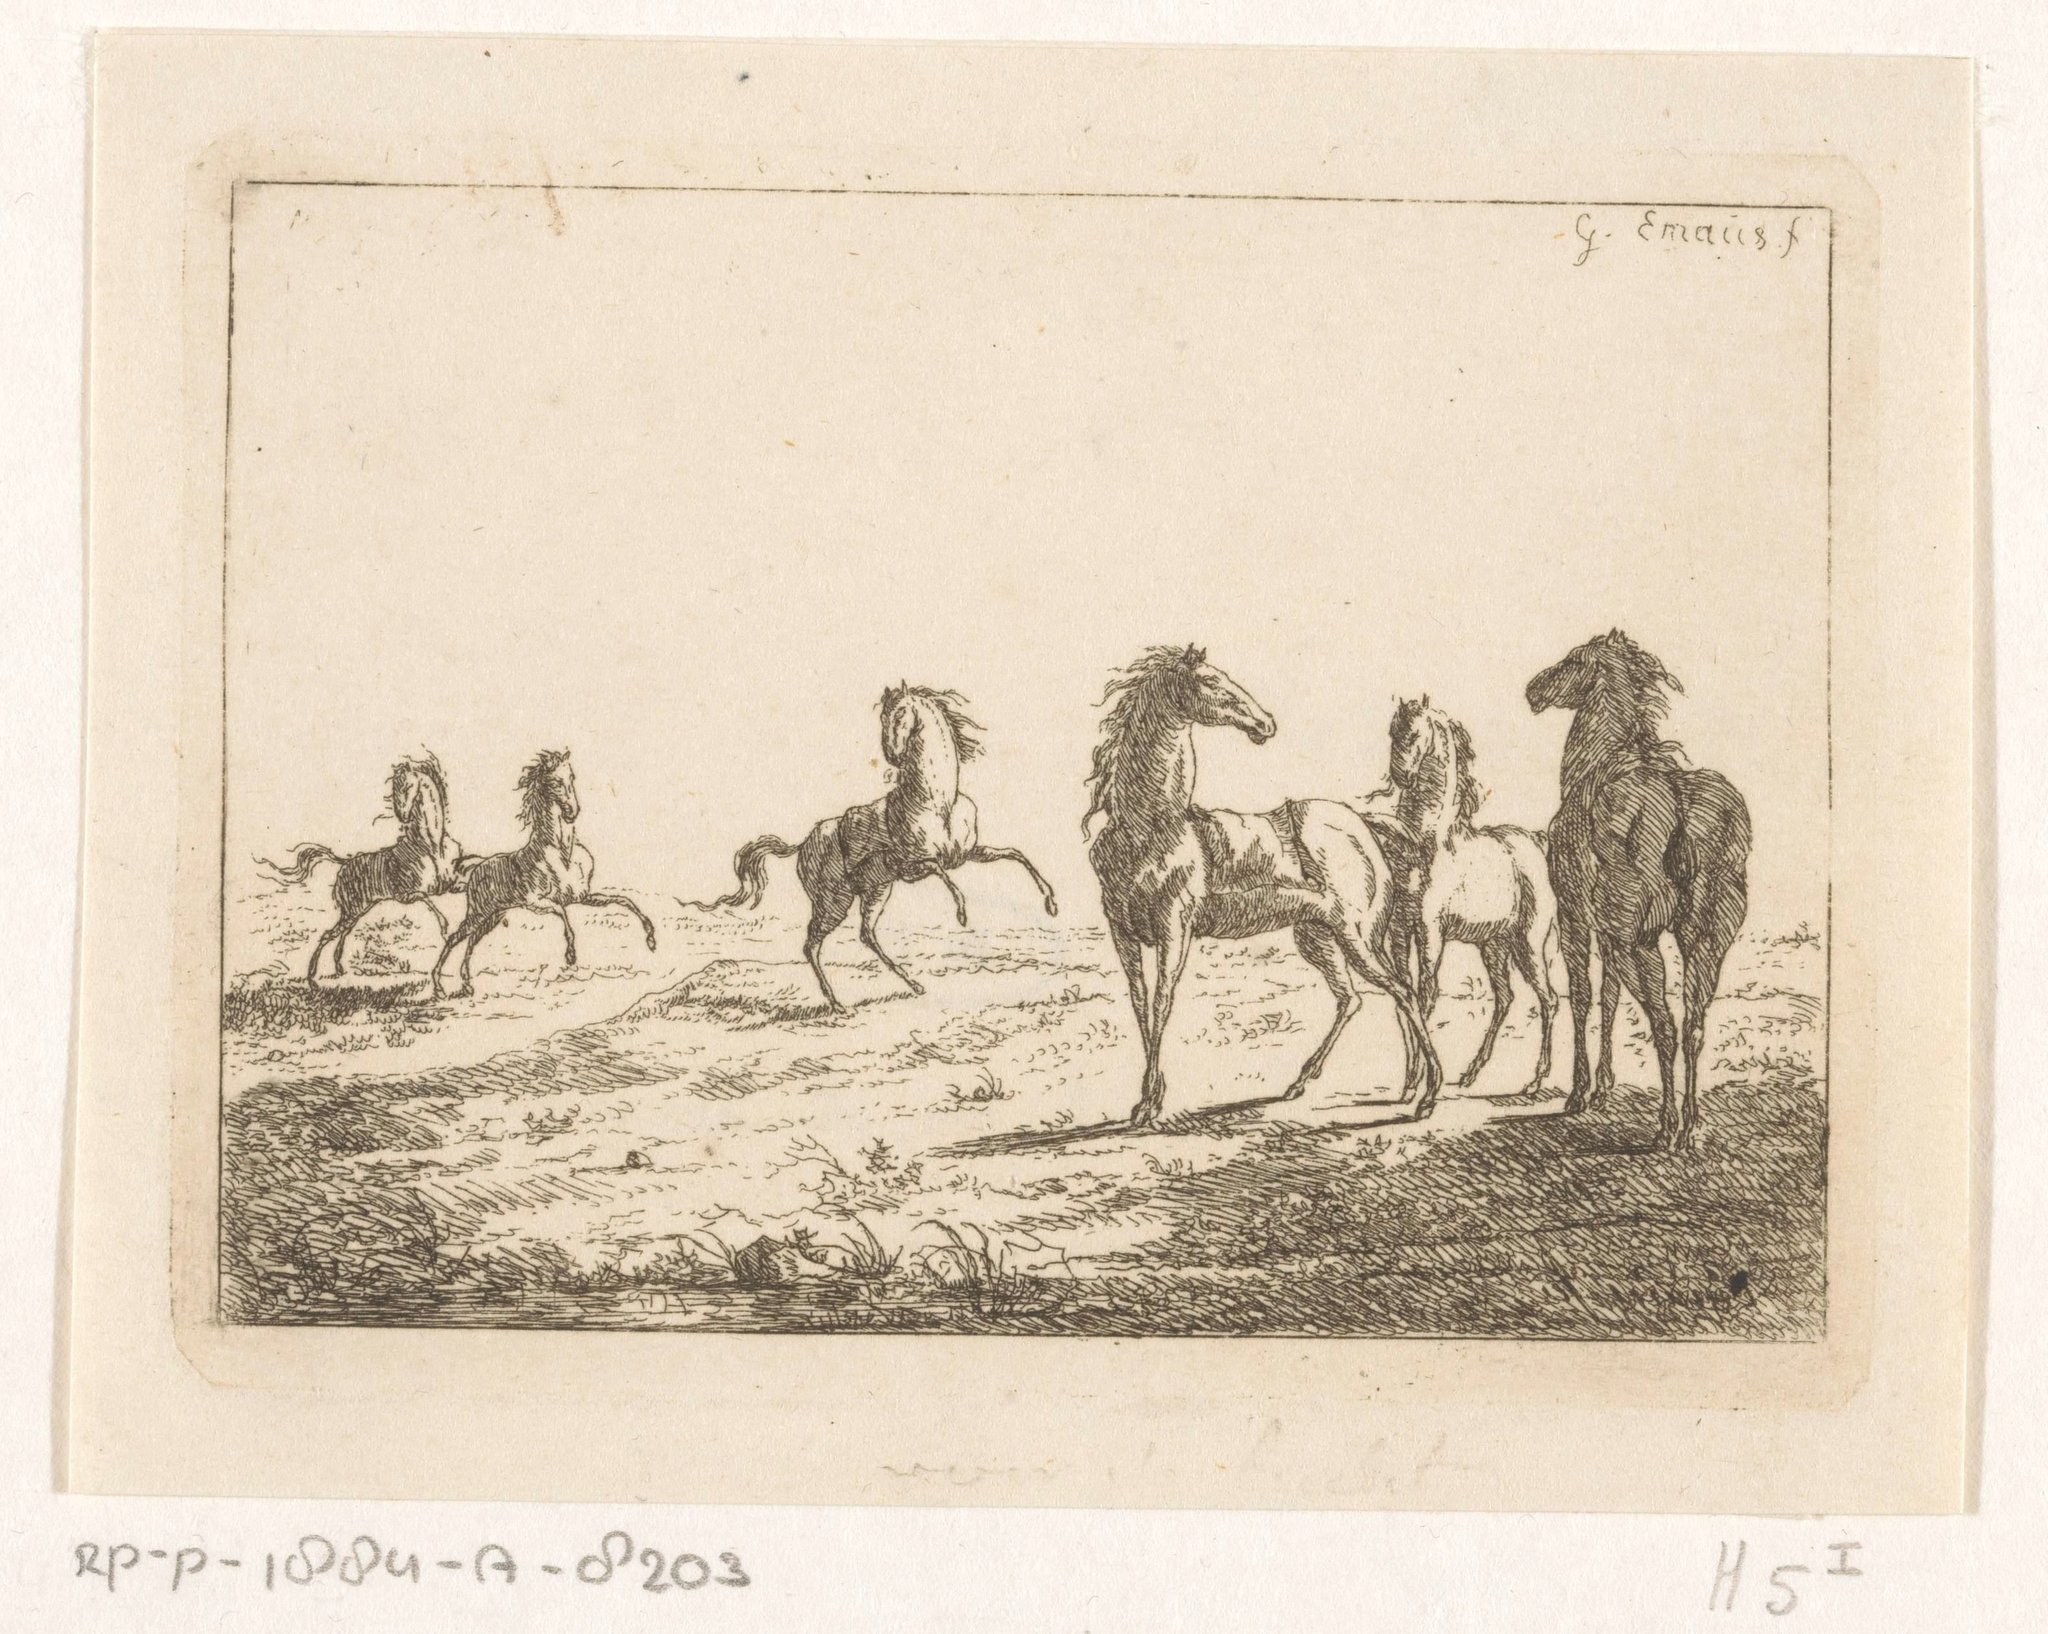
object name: print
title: Kudde wilde paarden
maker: gerardus emaus de micault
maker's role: draughtsman, print maker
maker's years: 1798-1863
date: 1813-1863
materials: paper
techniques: etching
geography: netherlands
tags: horse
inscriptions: collector's mark: Lugt 2228